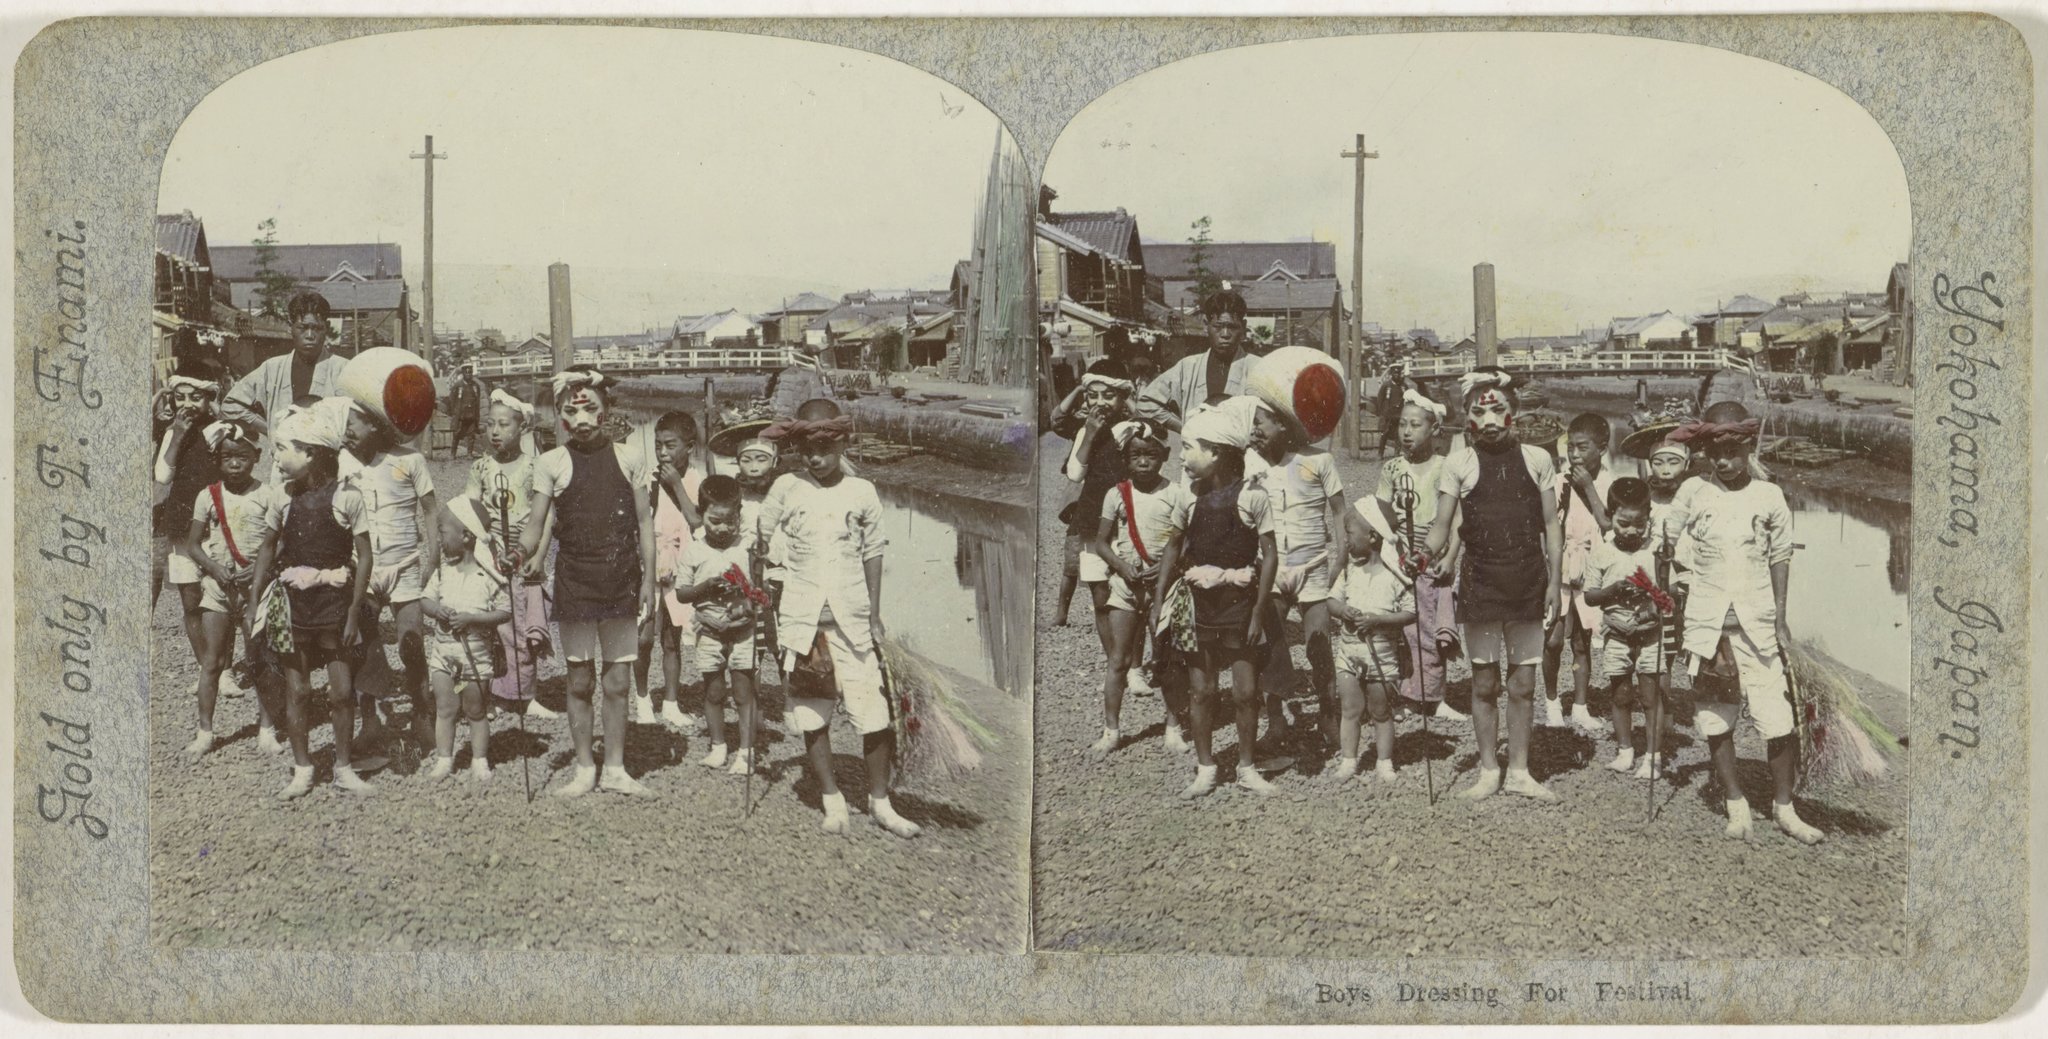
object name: stereograph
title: Feestelijk uitgedoste kinderen voor een festival in Japan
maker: t. enami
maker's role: publisher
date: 1900-1907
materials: paper, cardboard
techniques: hand coloring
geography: japan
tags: festivities, japan